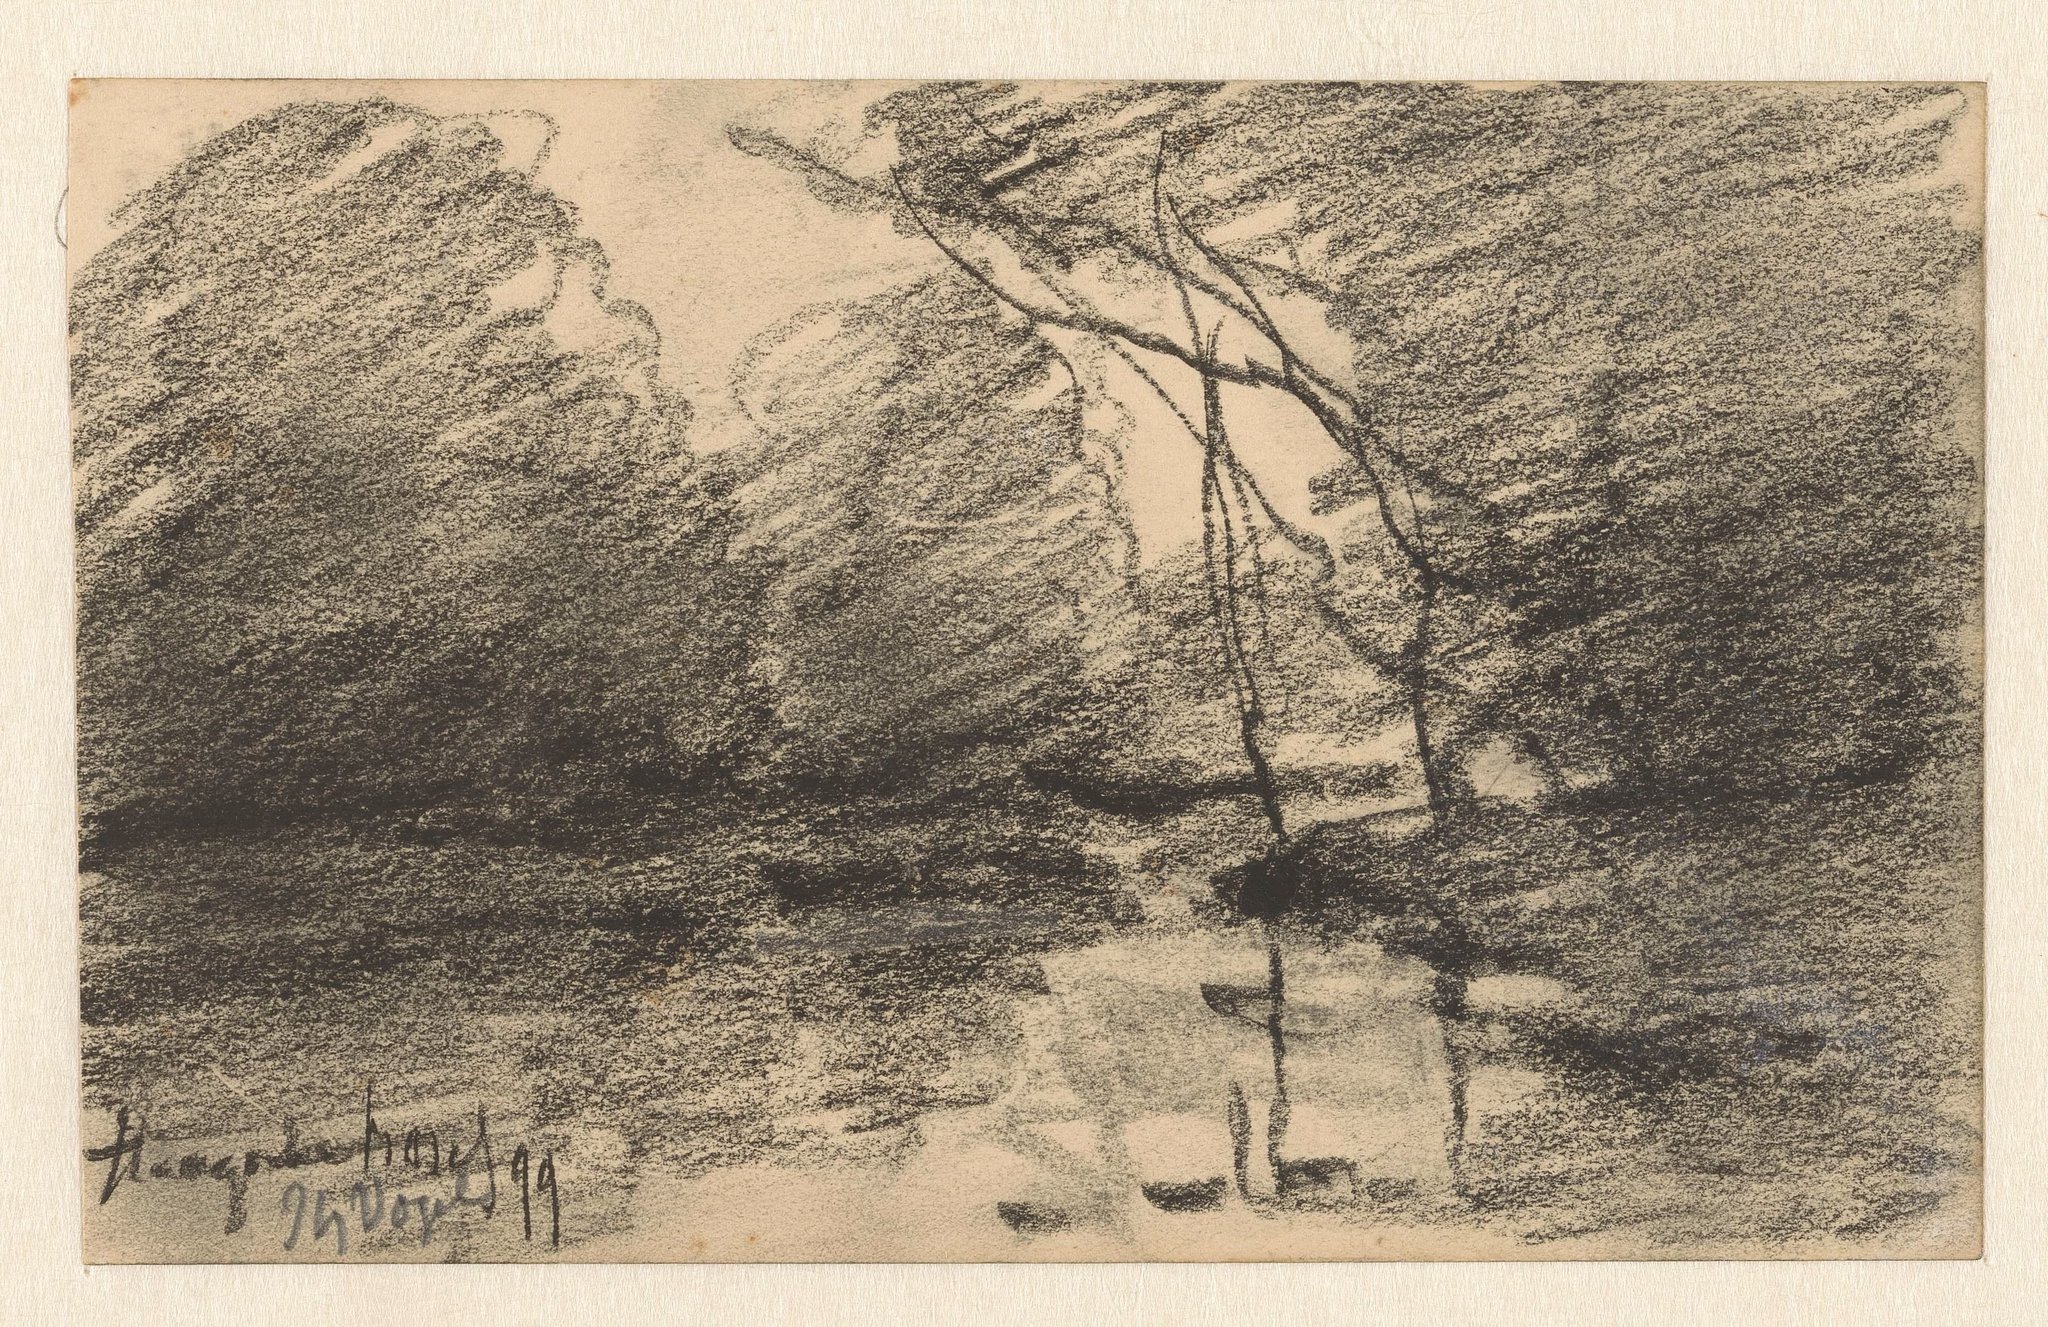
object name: drawing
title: Gezicht in het Haagse Bos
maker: johannes gijsbert vogel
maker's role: draughtsman, painter, print maker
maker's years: 1828-1915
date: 1899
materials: chalk, paper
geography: the hague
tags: meadow, pasture, the hague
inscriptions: date